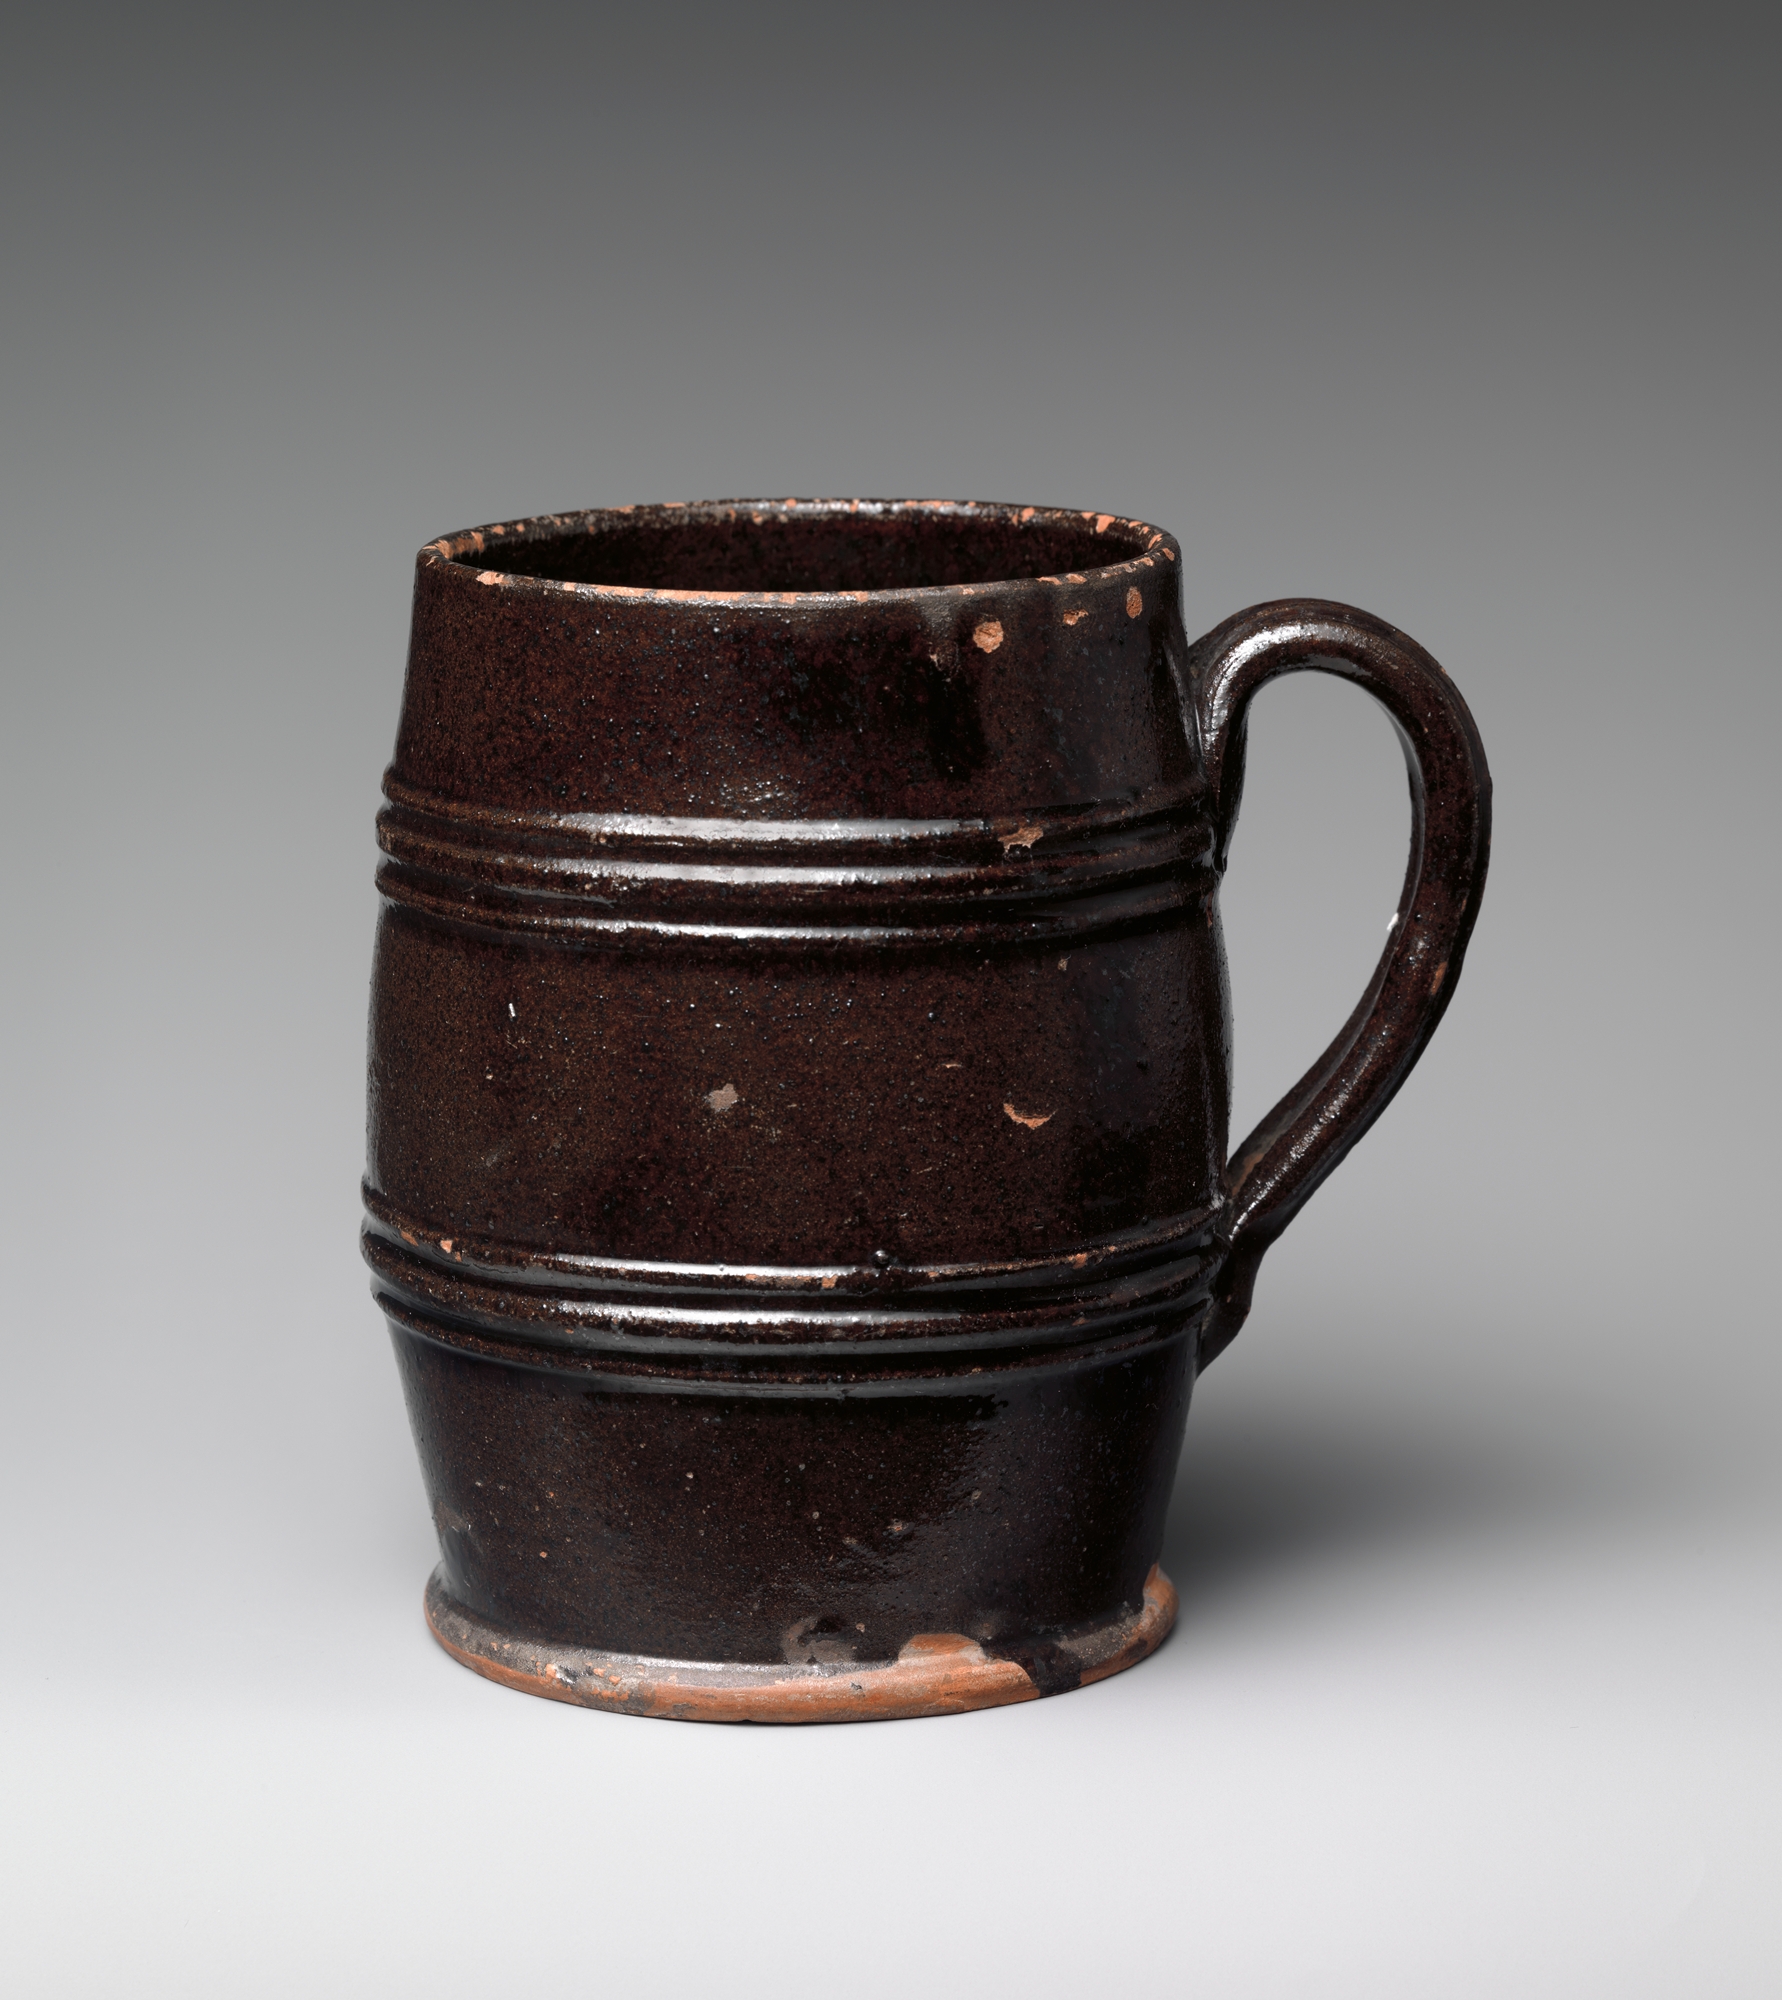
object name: mug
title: Barrel Mug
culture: american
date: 1700-1900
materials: earthenware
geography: united states